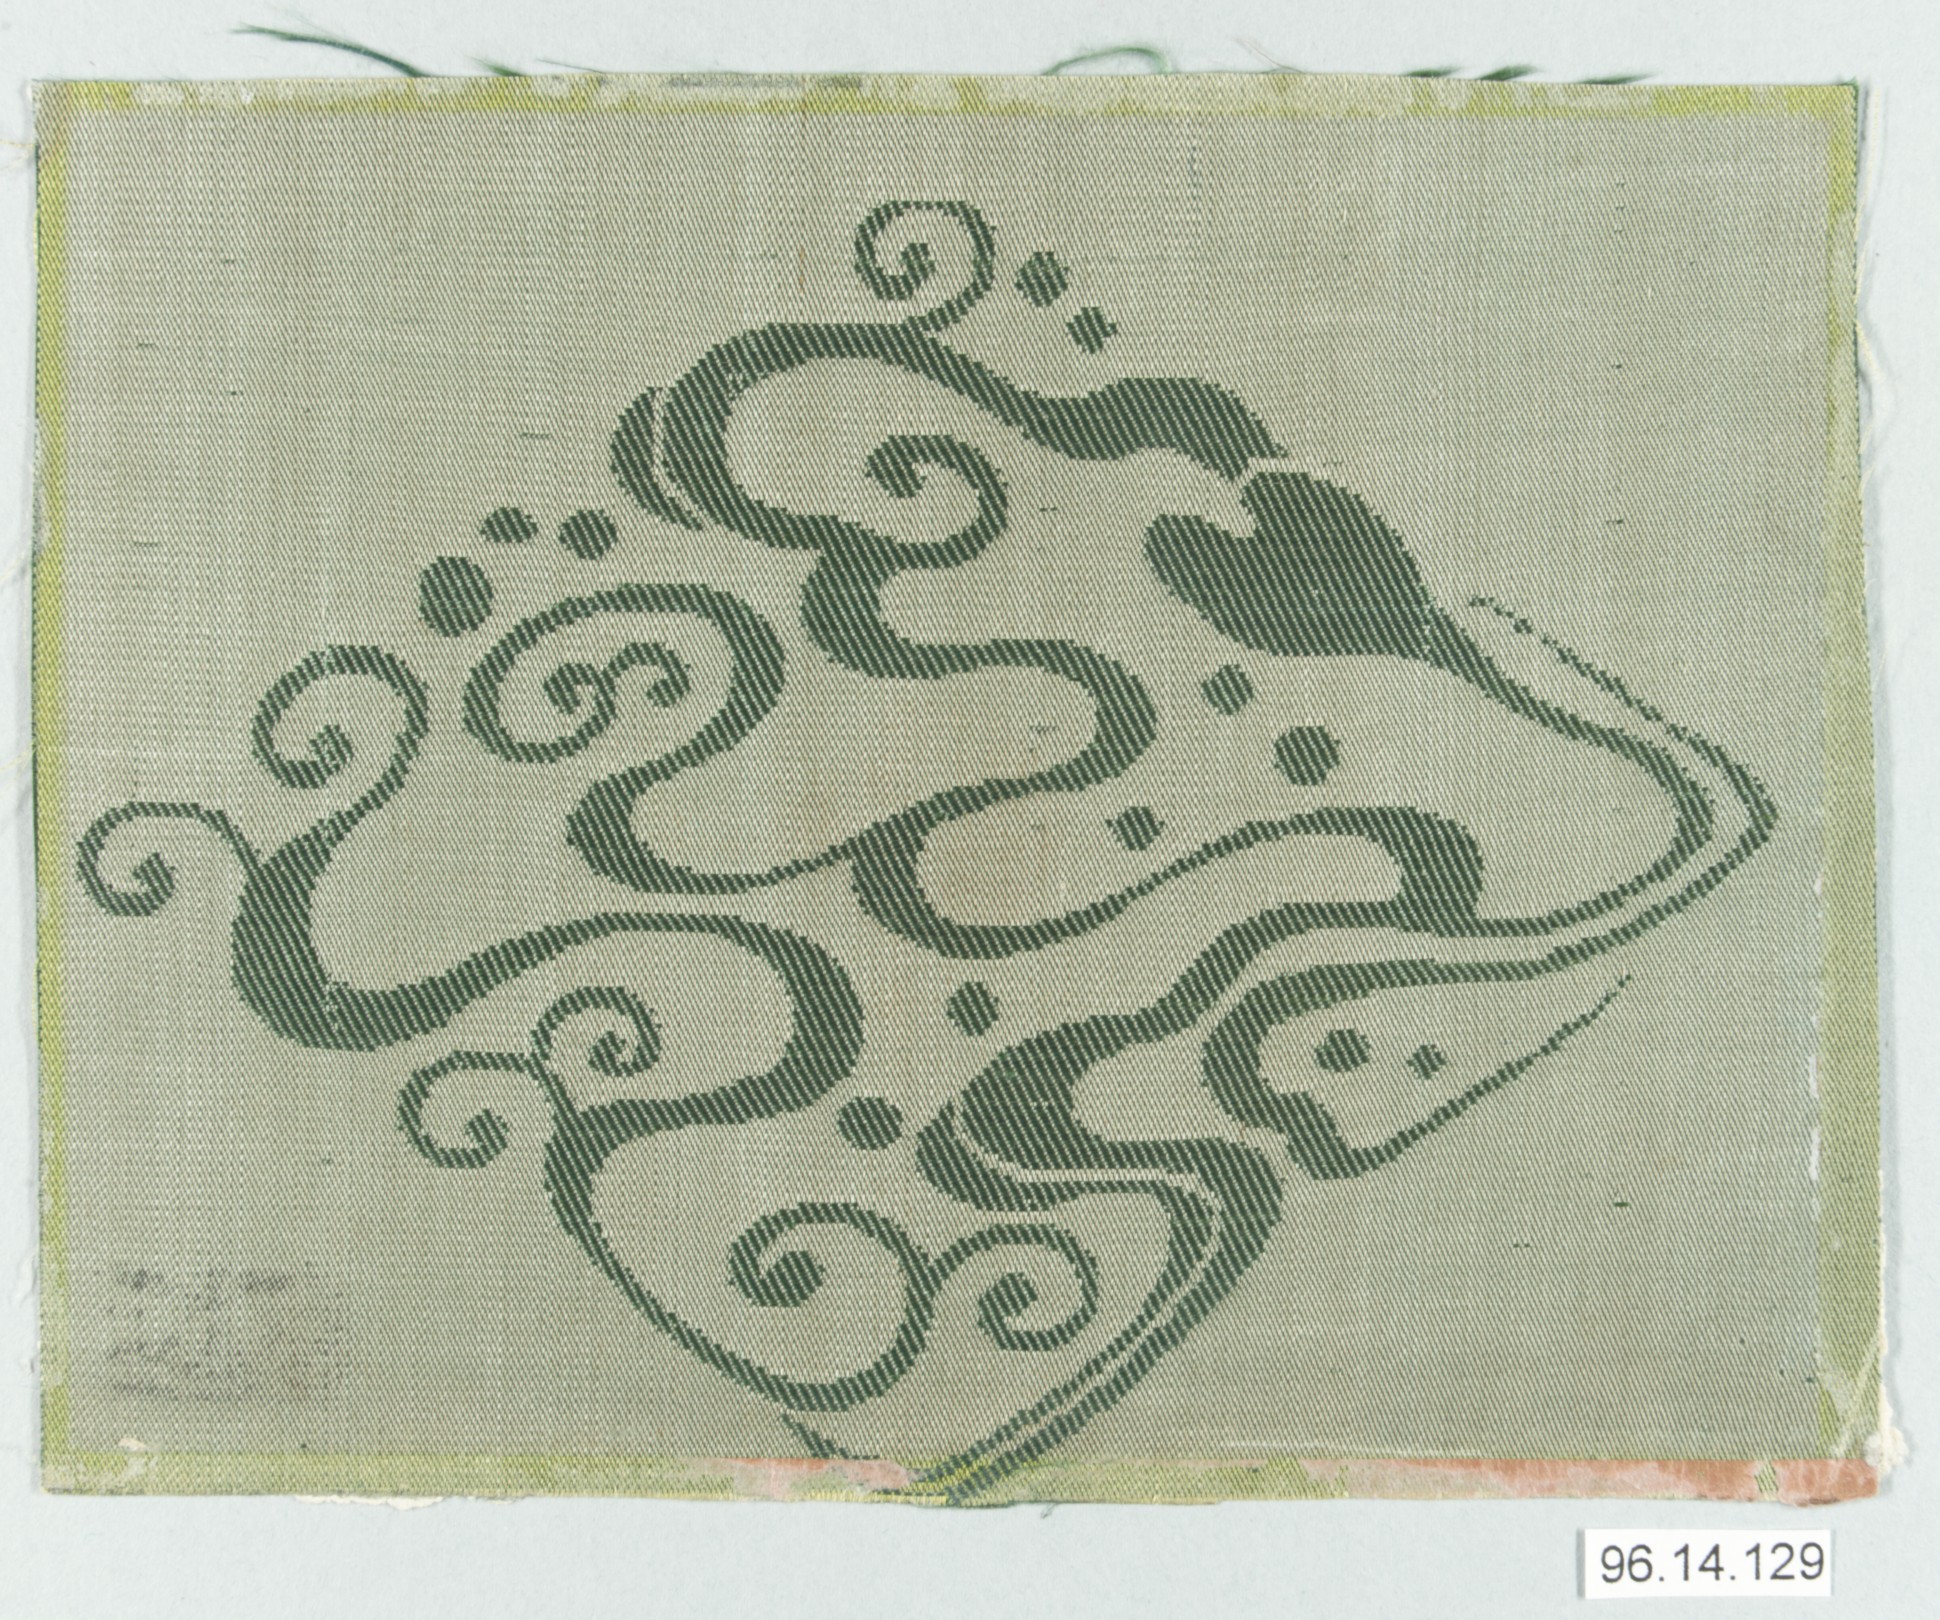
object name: piece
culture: japanese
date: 1767-1900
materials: silk